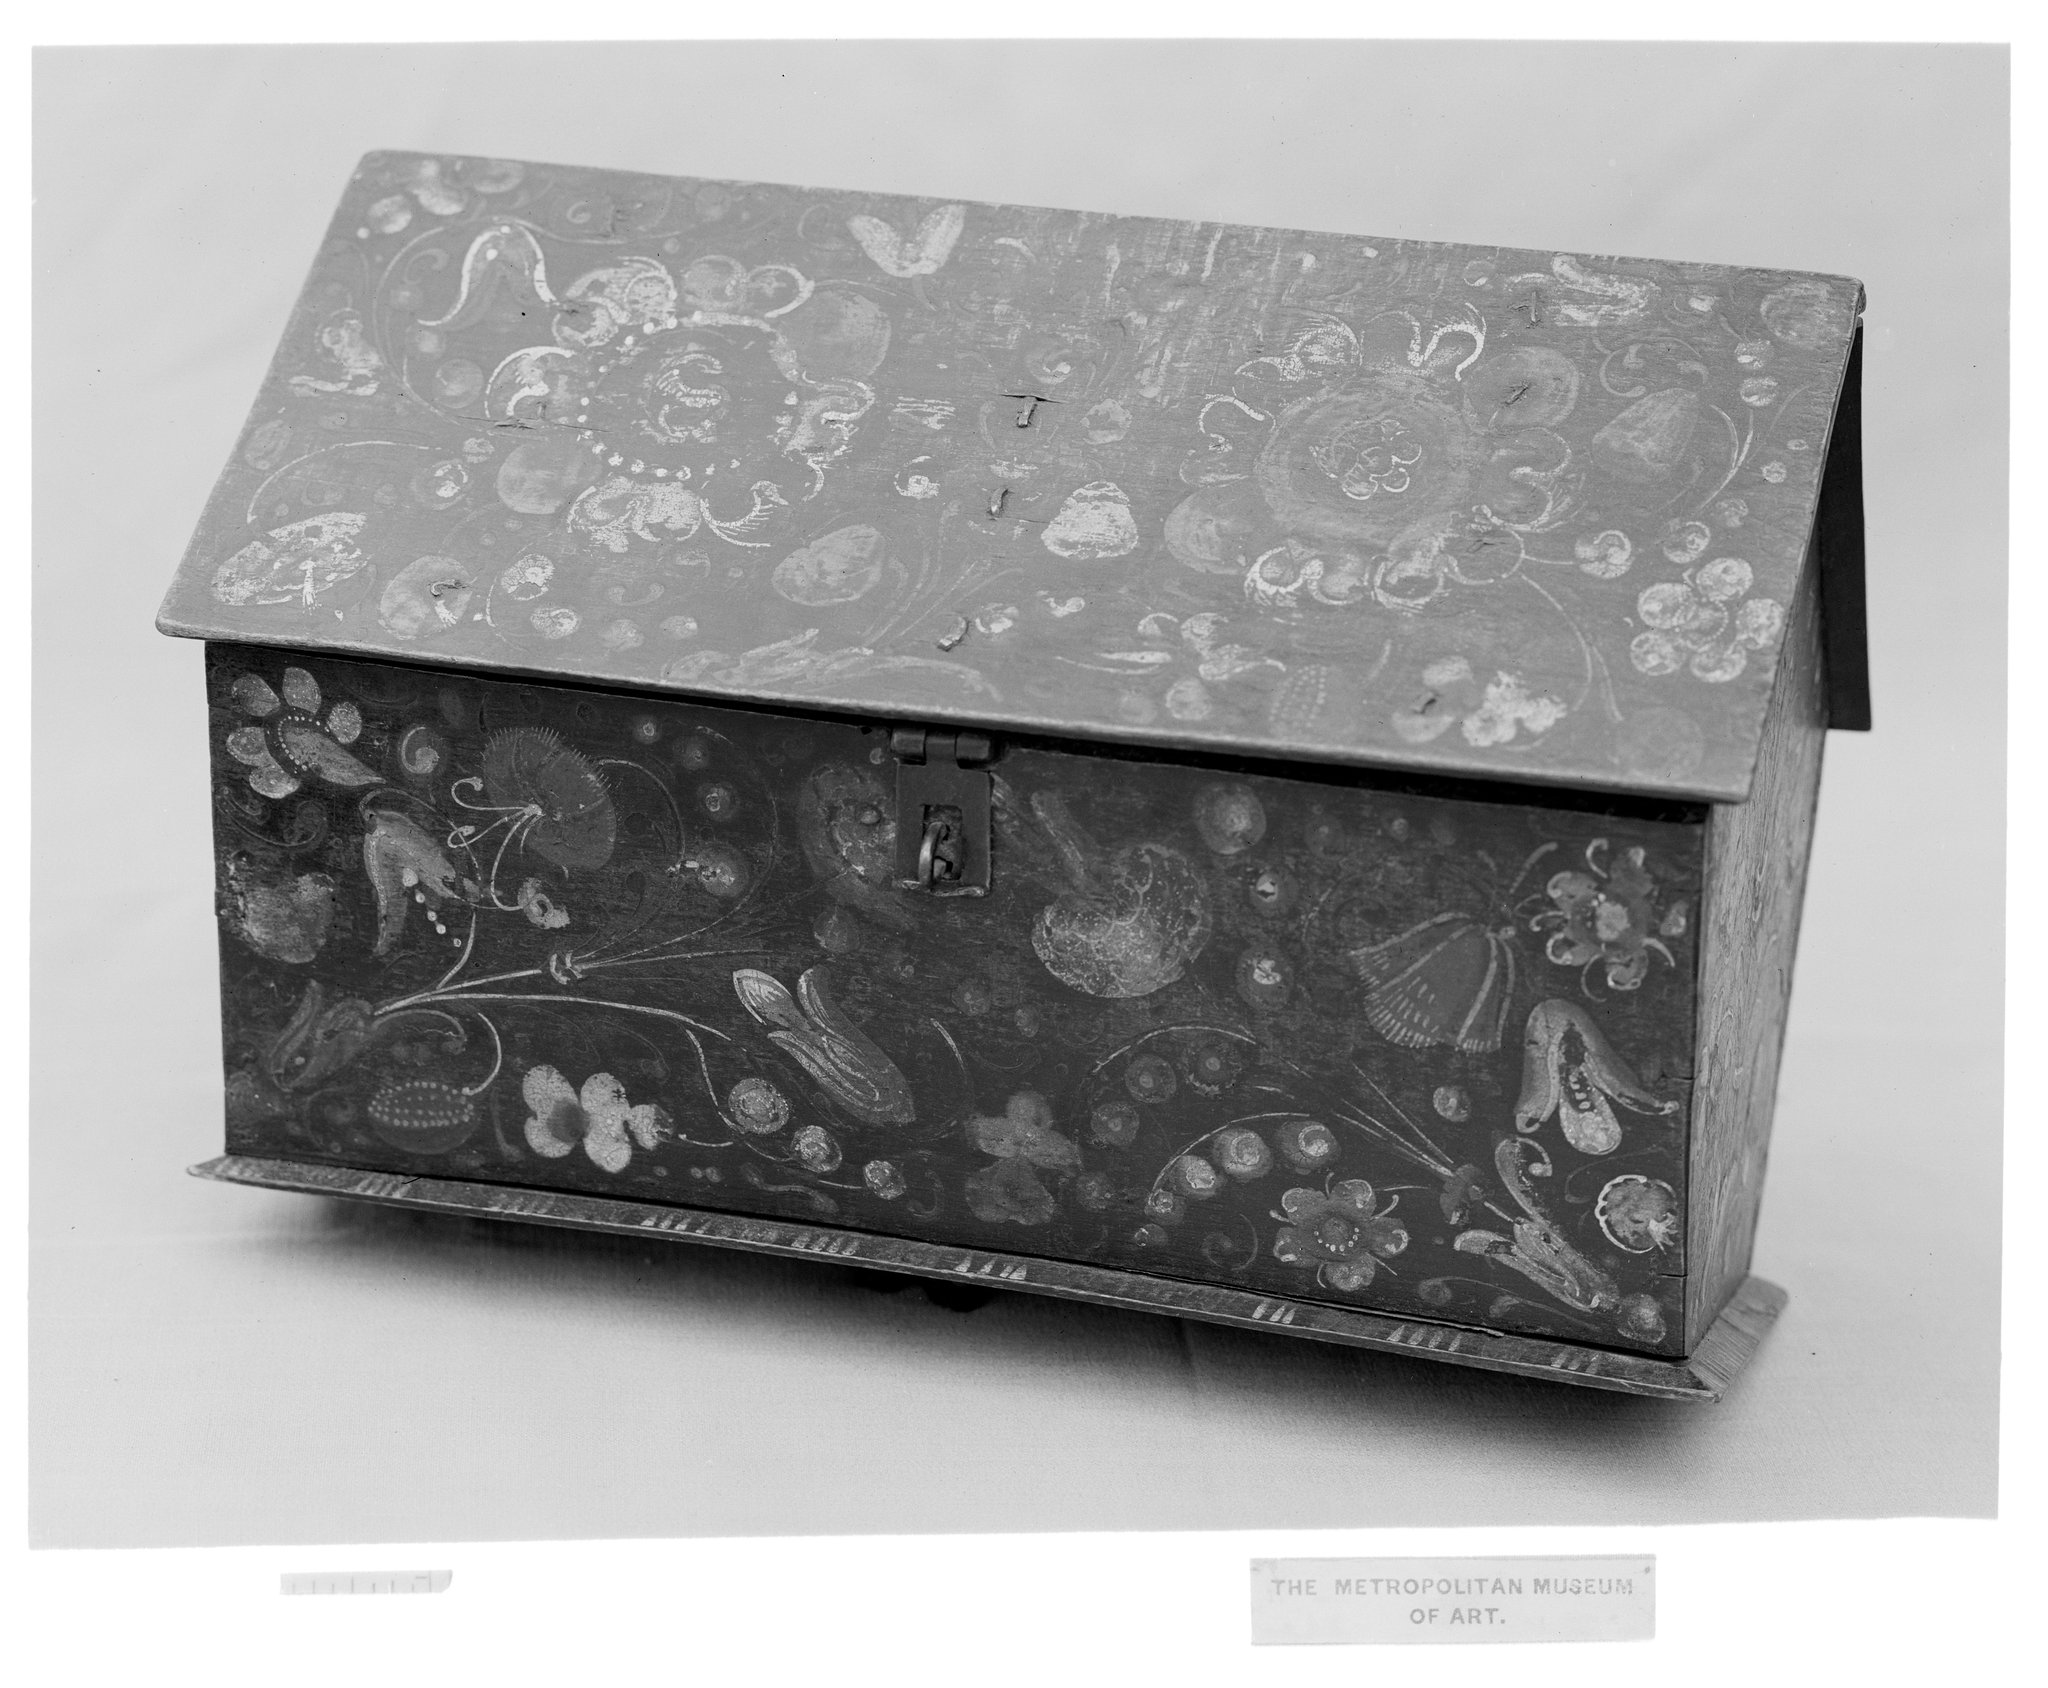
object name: box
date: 1601-1700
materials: wood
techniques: painting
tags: flowers,leaves